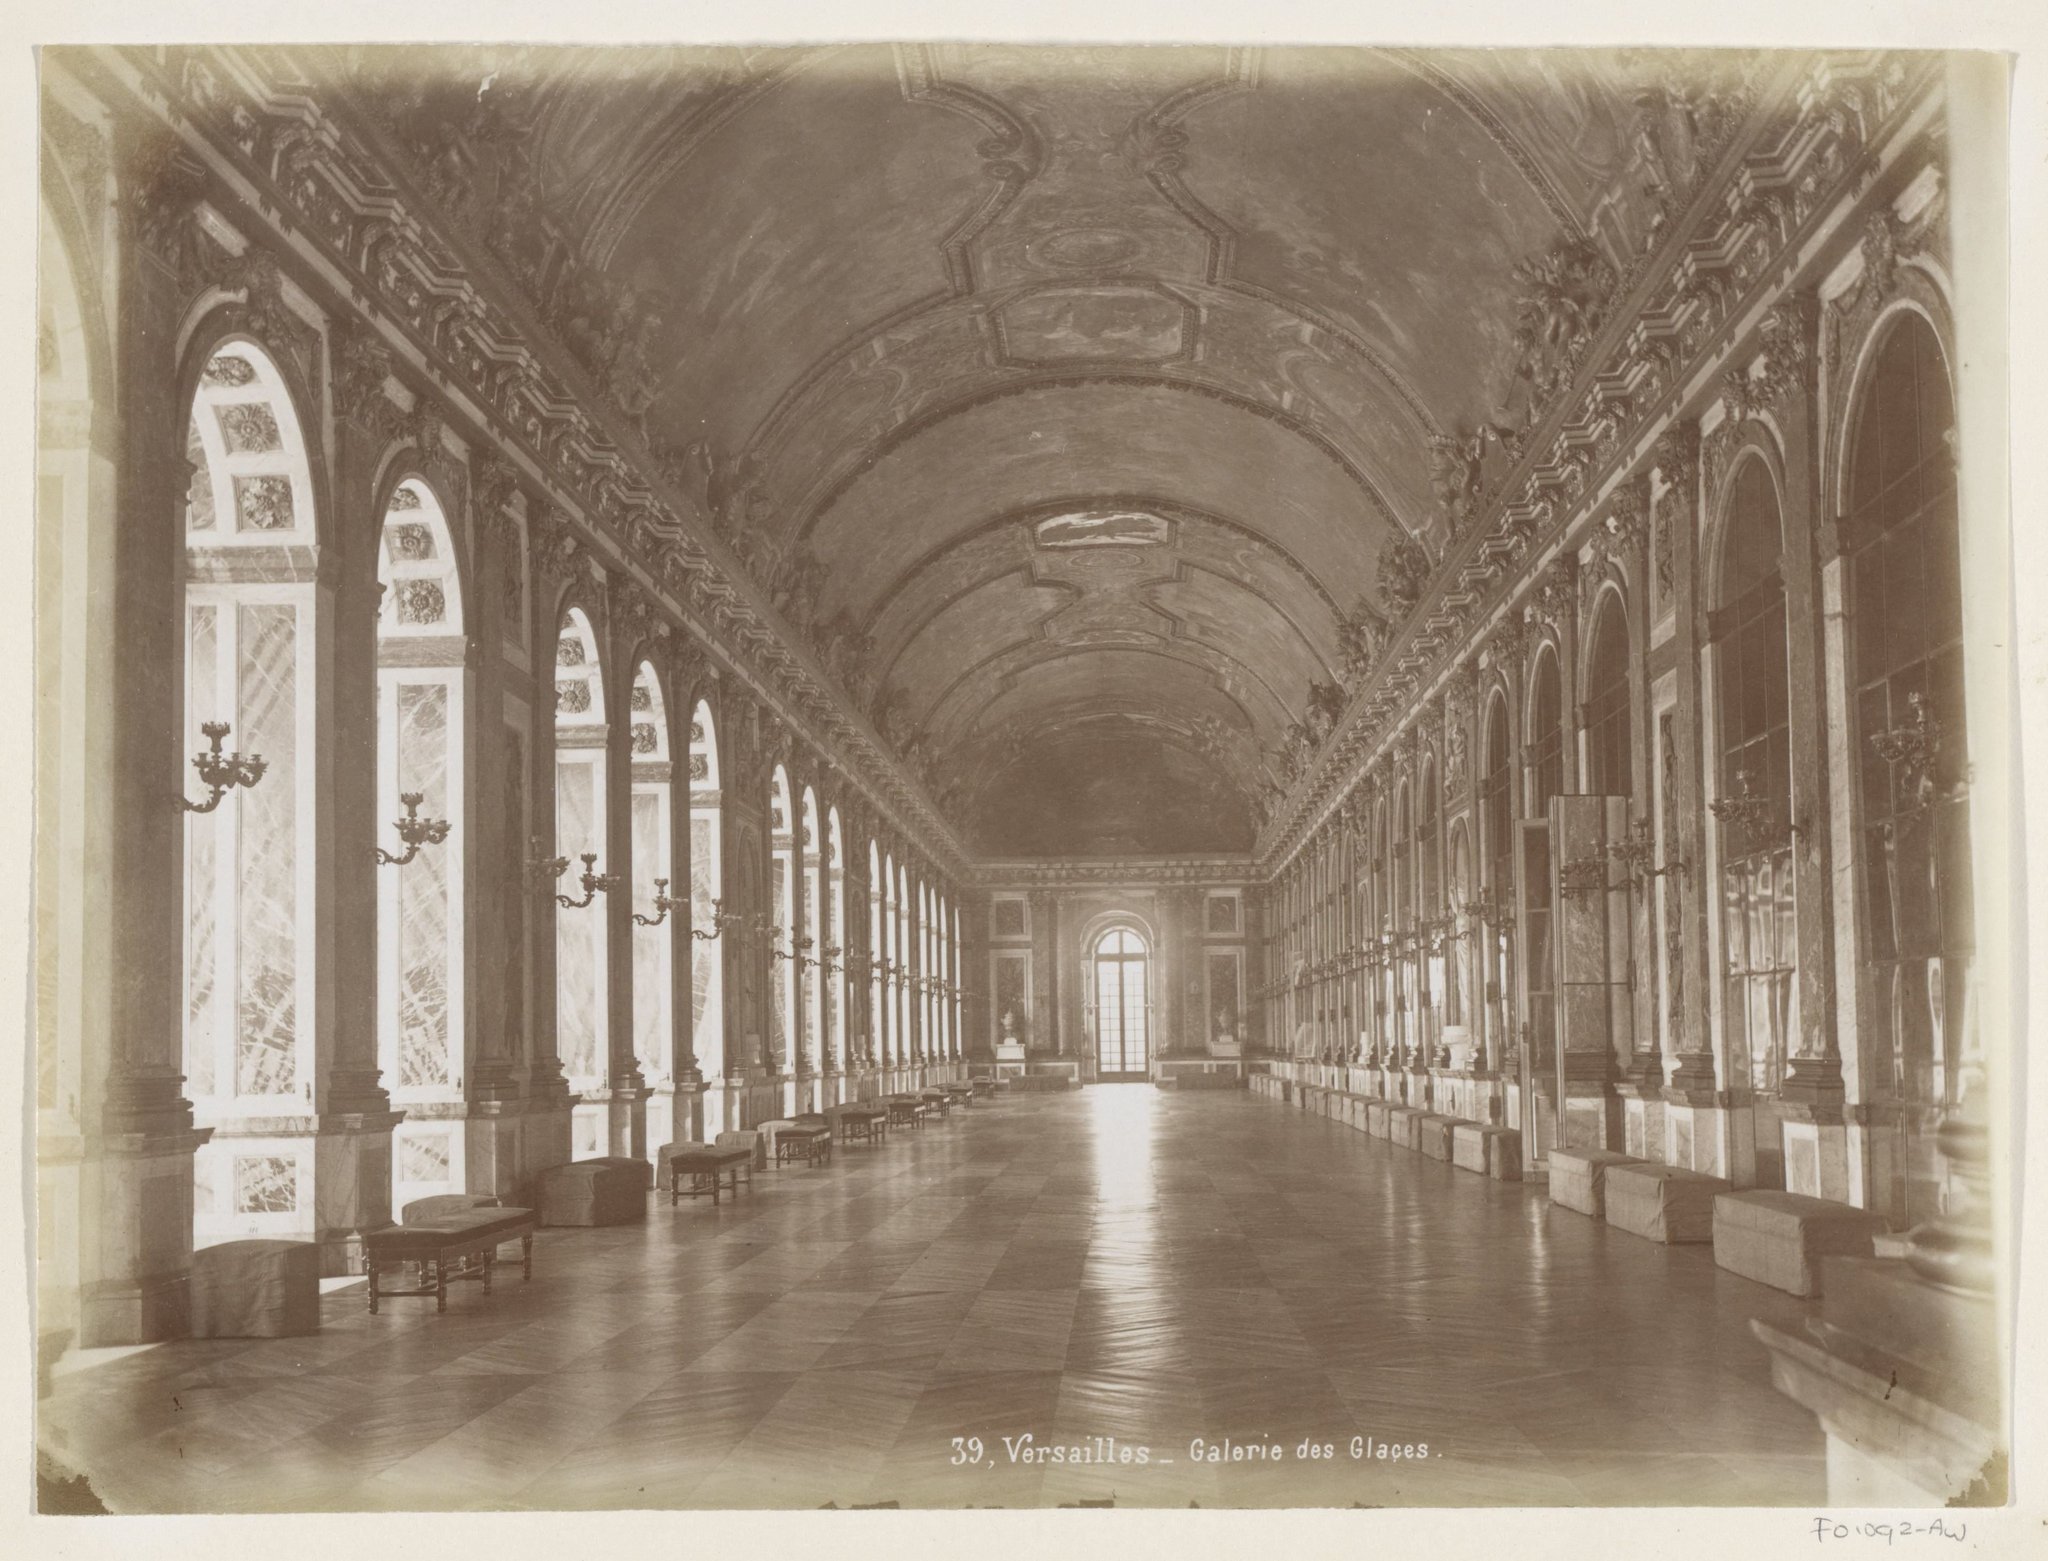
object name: photograph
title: Spiegelzaal in het Paleis van Versailles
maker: Anonymous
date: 1880-1900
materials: cardboard, paper, photographic support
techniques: albumen print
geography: versailles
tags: palace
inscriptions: negative number: ‘39’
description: Onderdeel van Reisalbum met foto's van bezienswaardigheden in België en Frankrijk.